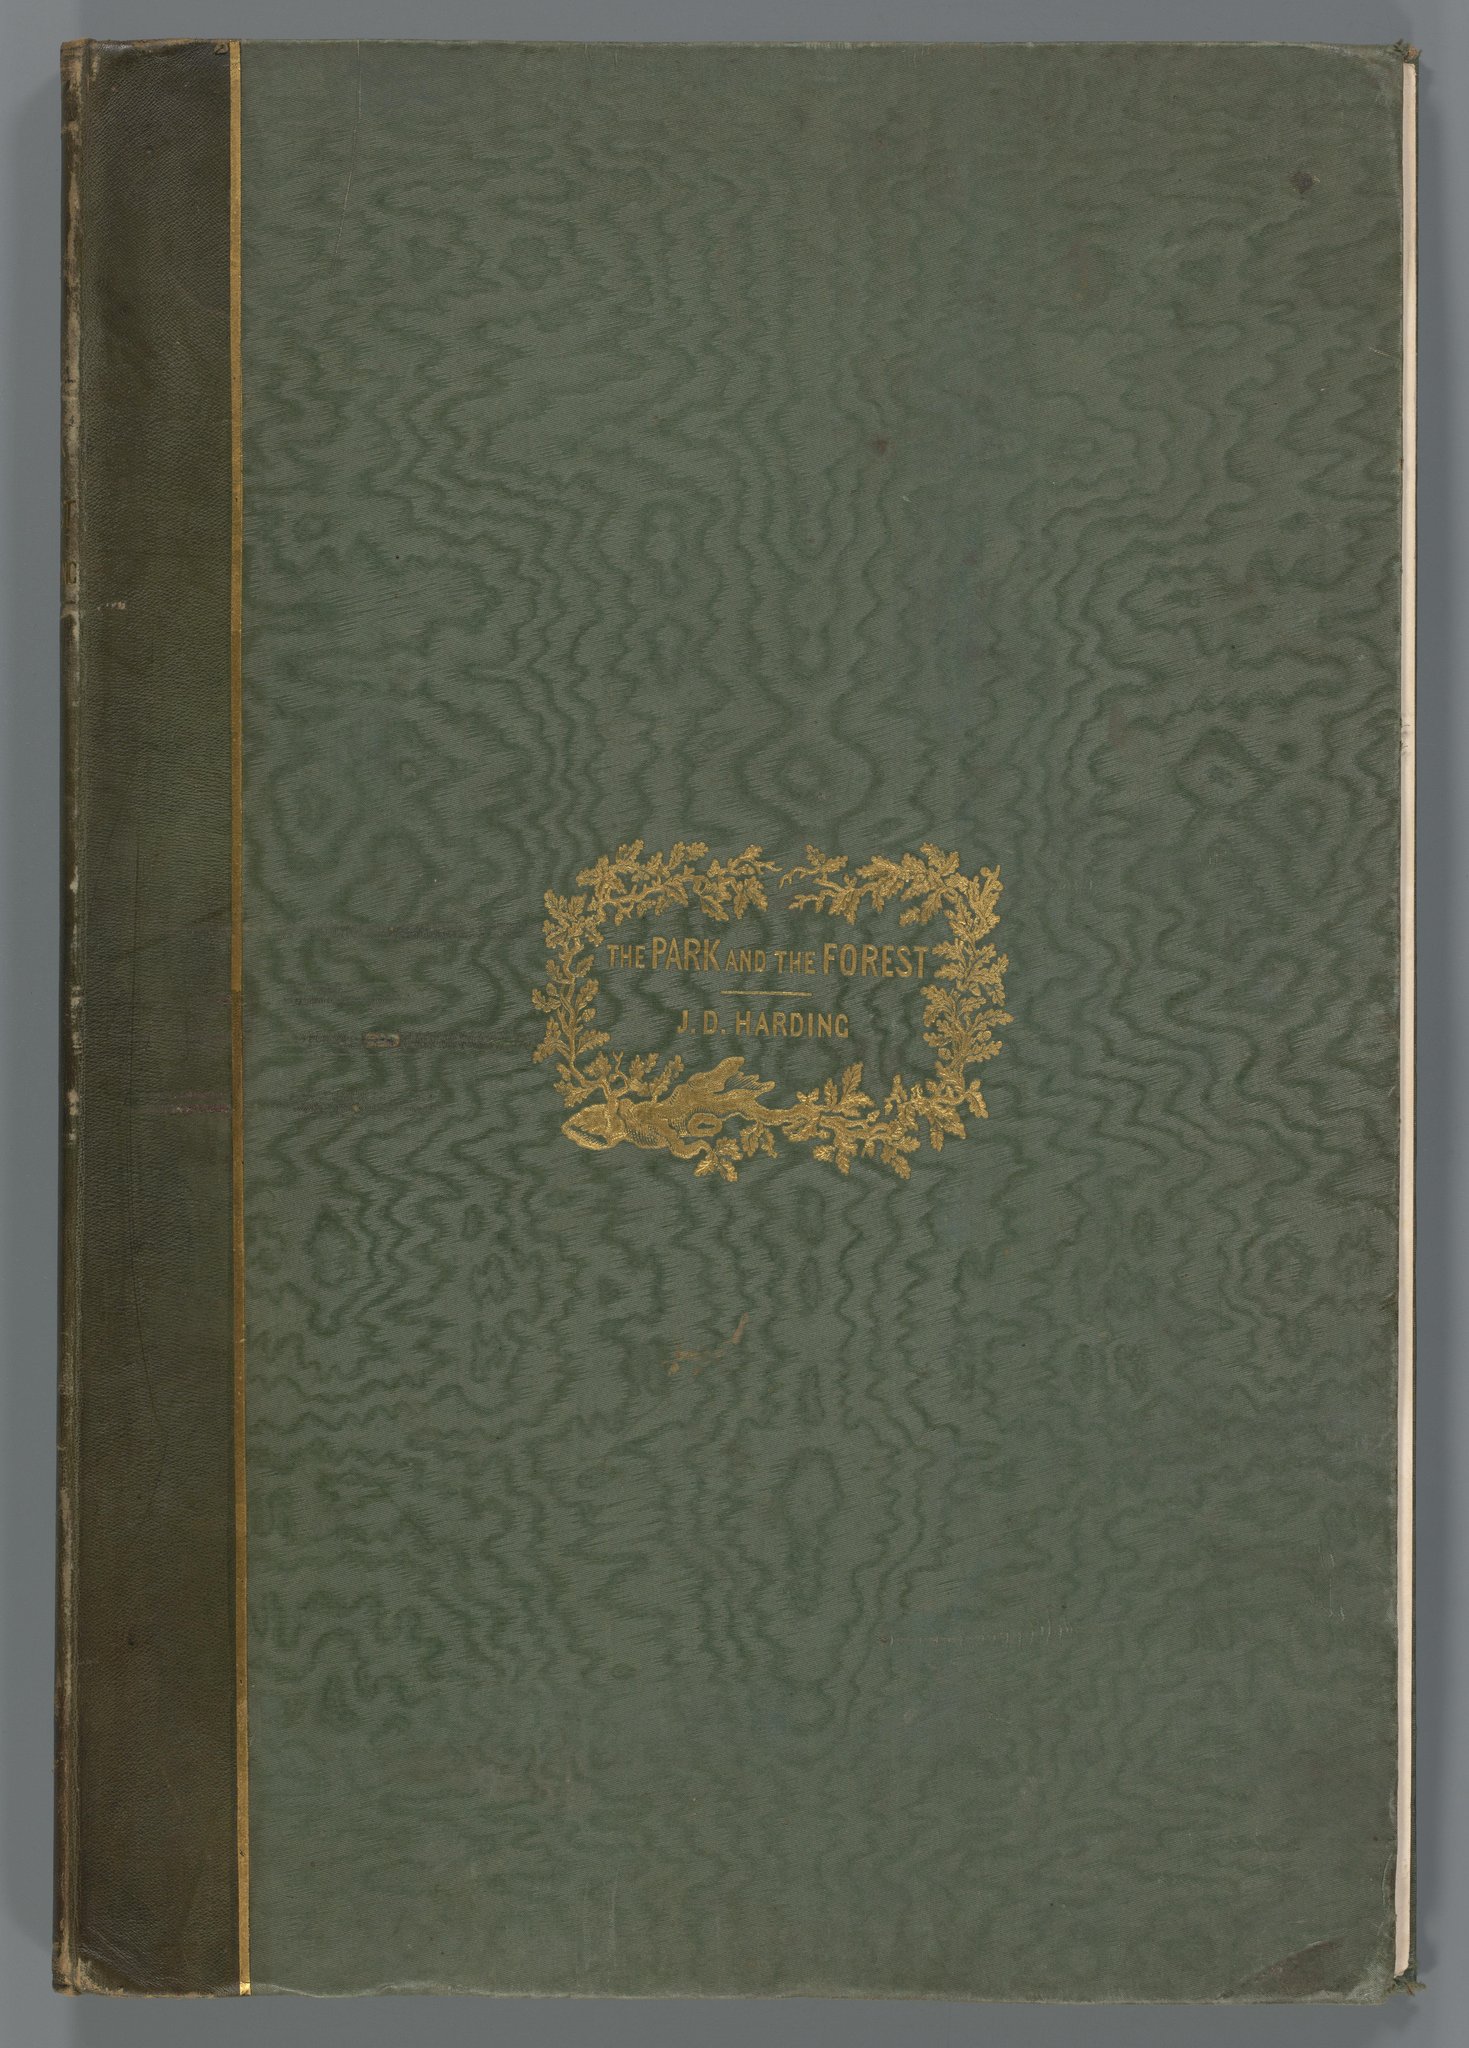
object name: wrapper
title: The Park and the Forest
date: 1841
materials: cardboard, leather, linen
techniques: bookbinding, printing, moire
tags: park, forest, wood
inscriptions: check stamp: ‘(...) Licence [...] H.A. Koocks/ patent’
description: Goudopdruk in de vorm van takken en bladeren om de titel. In de omslag een serie van 24 lithografieën met landschappen door James Duffield Harding.